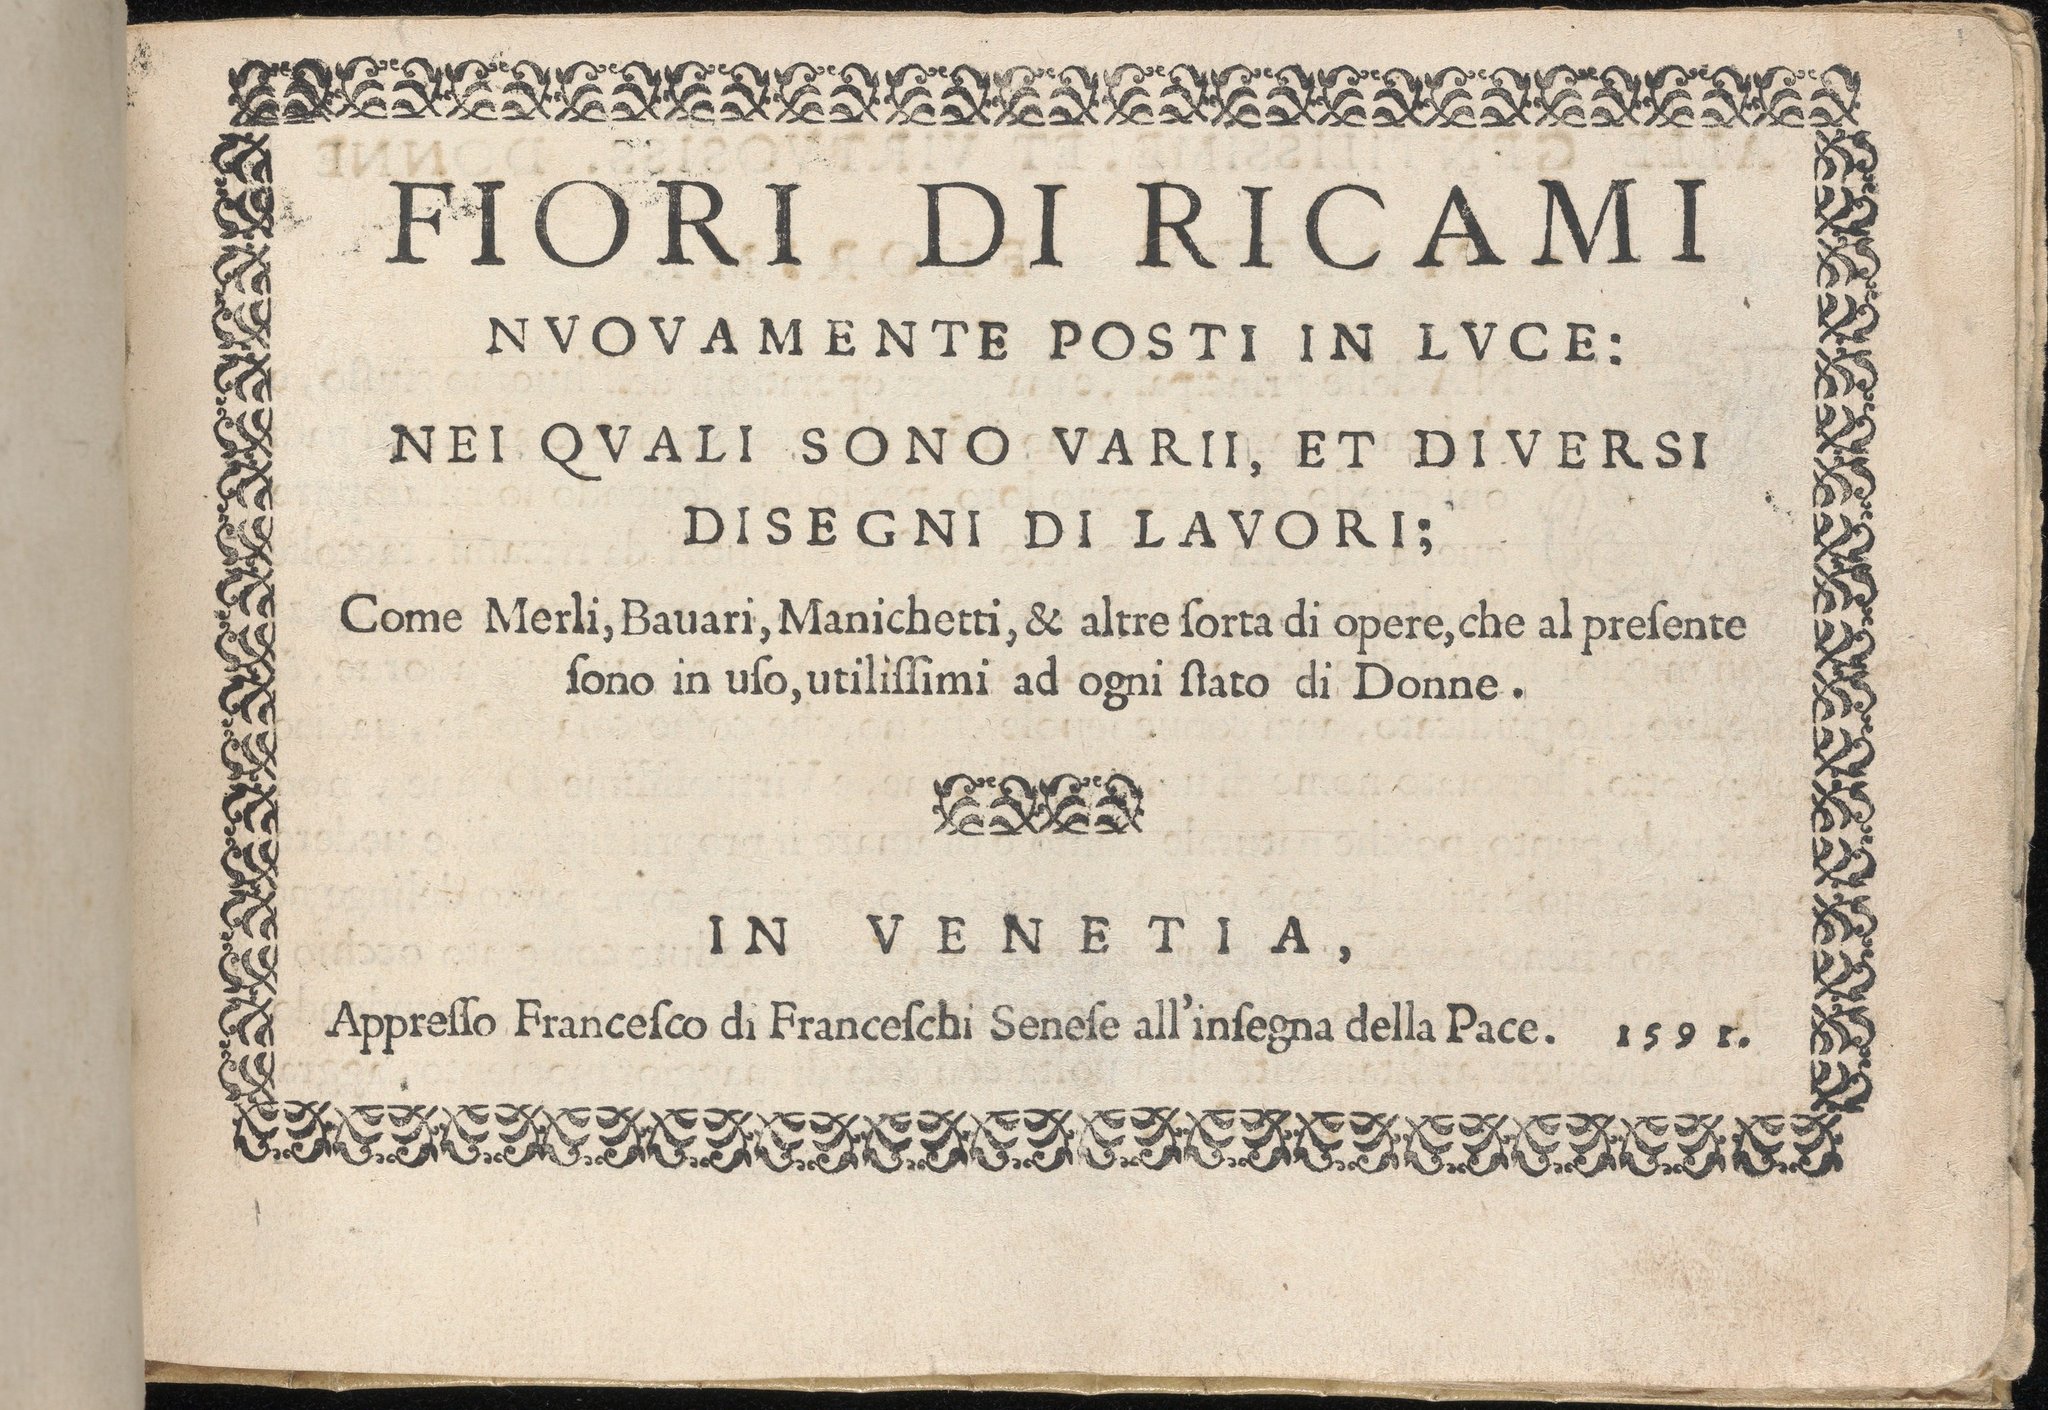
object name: book print ornament archiecture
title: Fiori di Ricami Nuovamente Posti in Luce, title page (recto)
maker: matteo florimi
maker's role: designer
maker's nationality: italian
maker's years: 1581-1613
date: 1591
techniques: woodcut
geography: italy